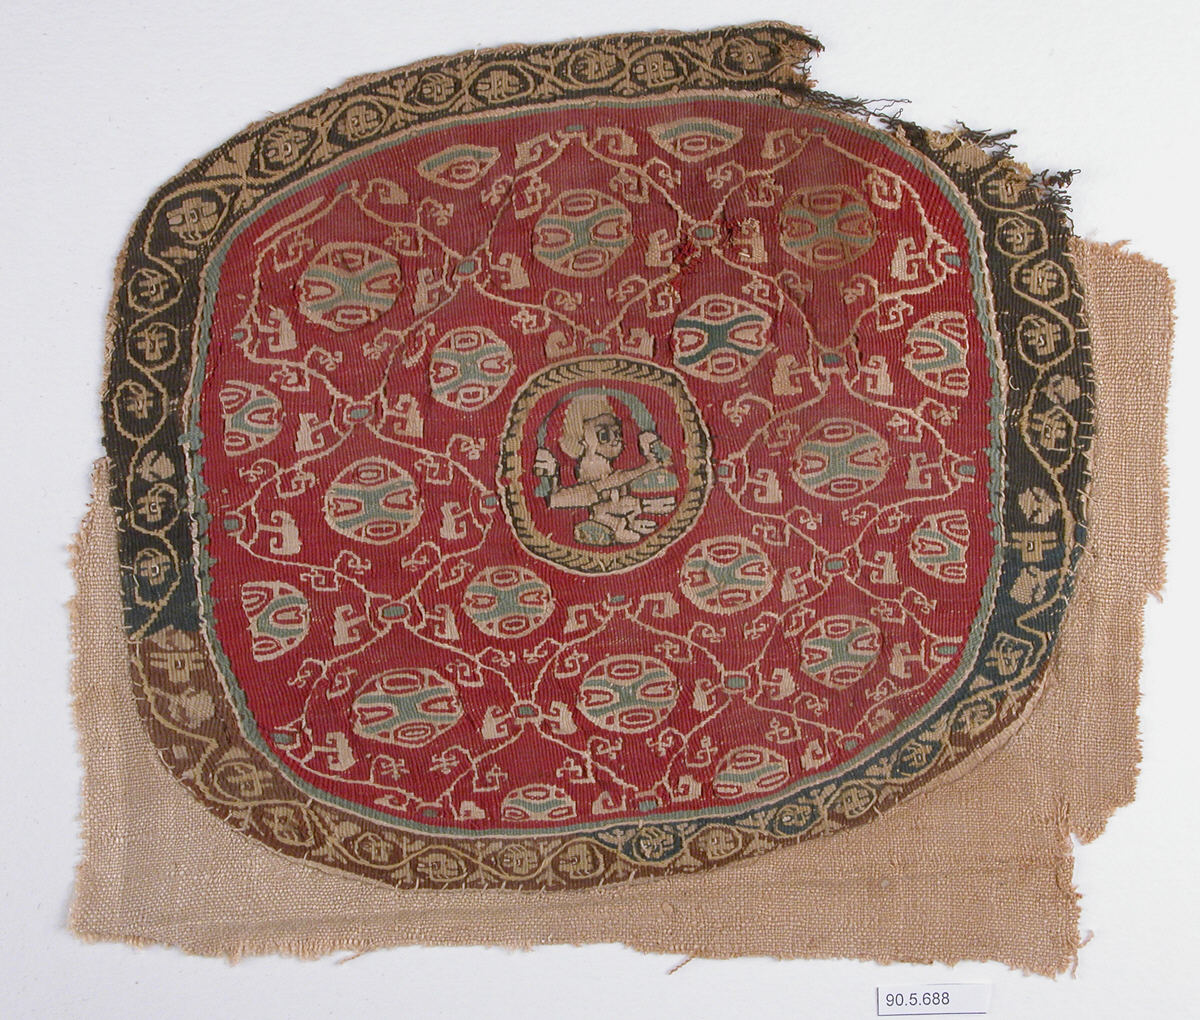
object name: textile fragment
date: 601-800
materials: linen, wool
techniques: weave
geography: egypt